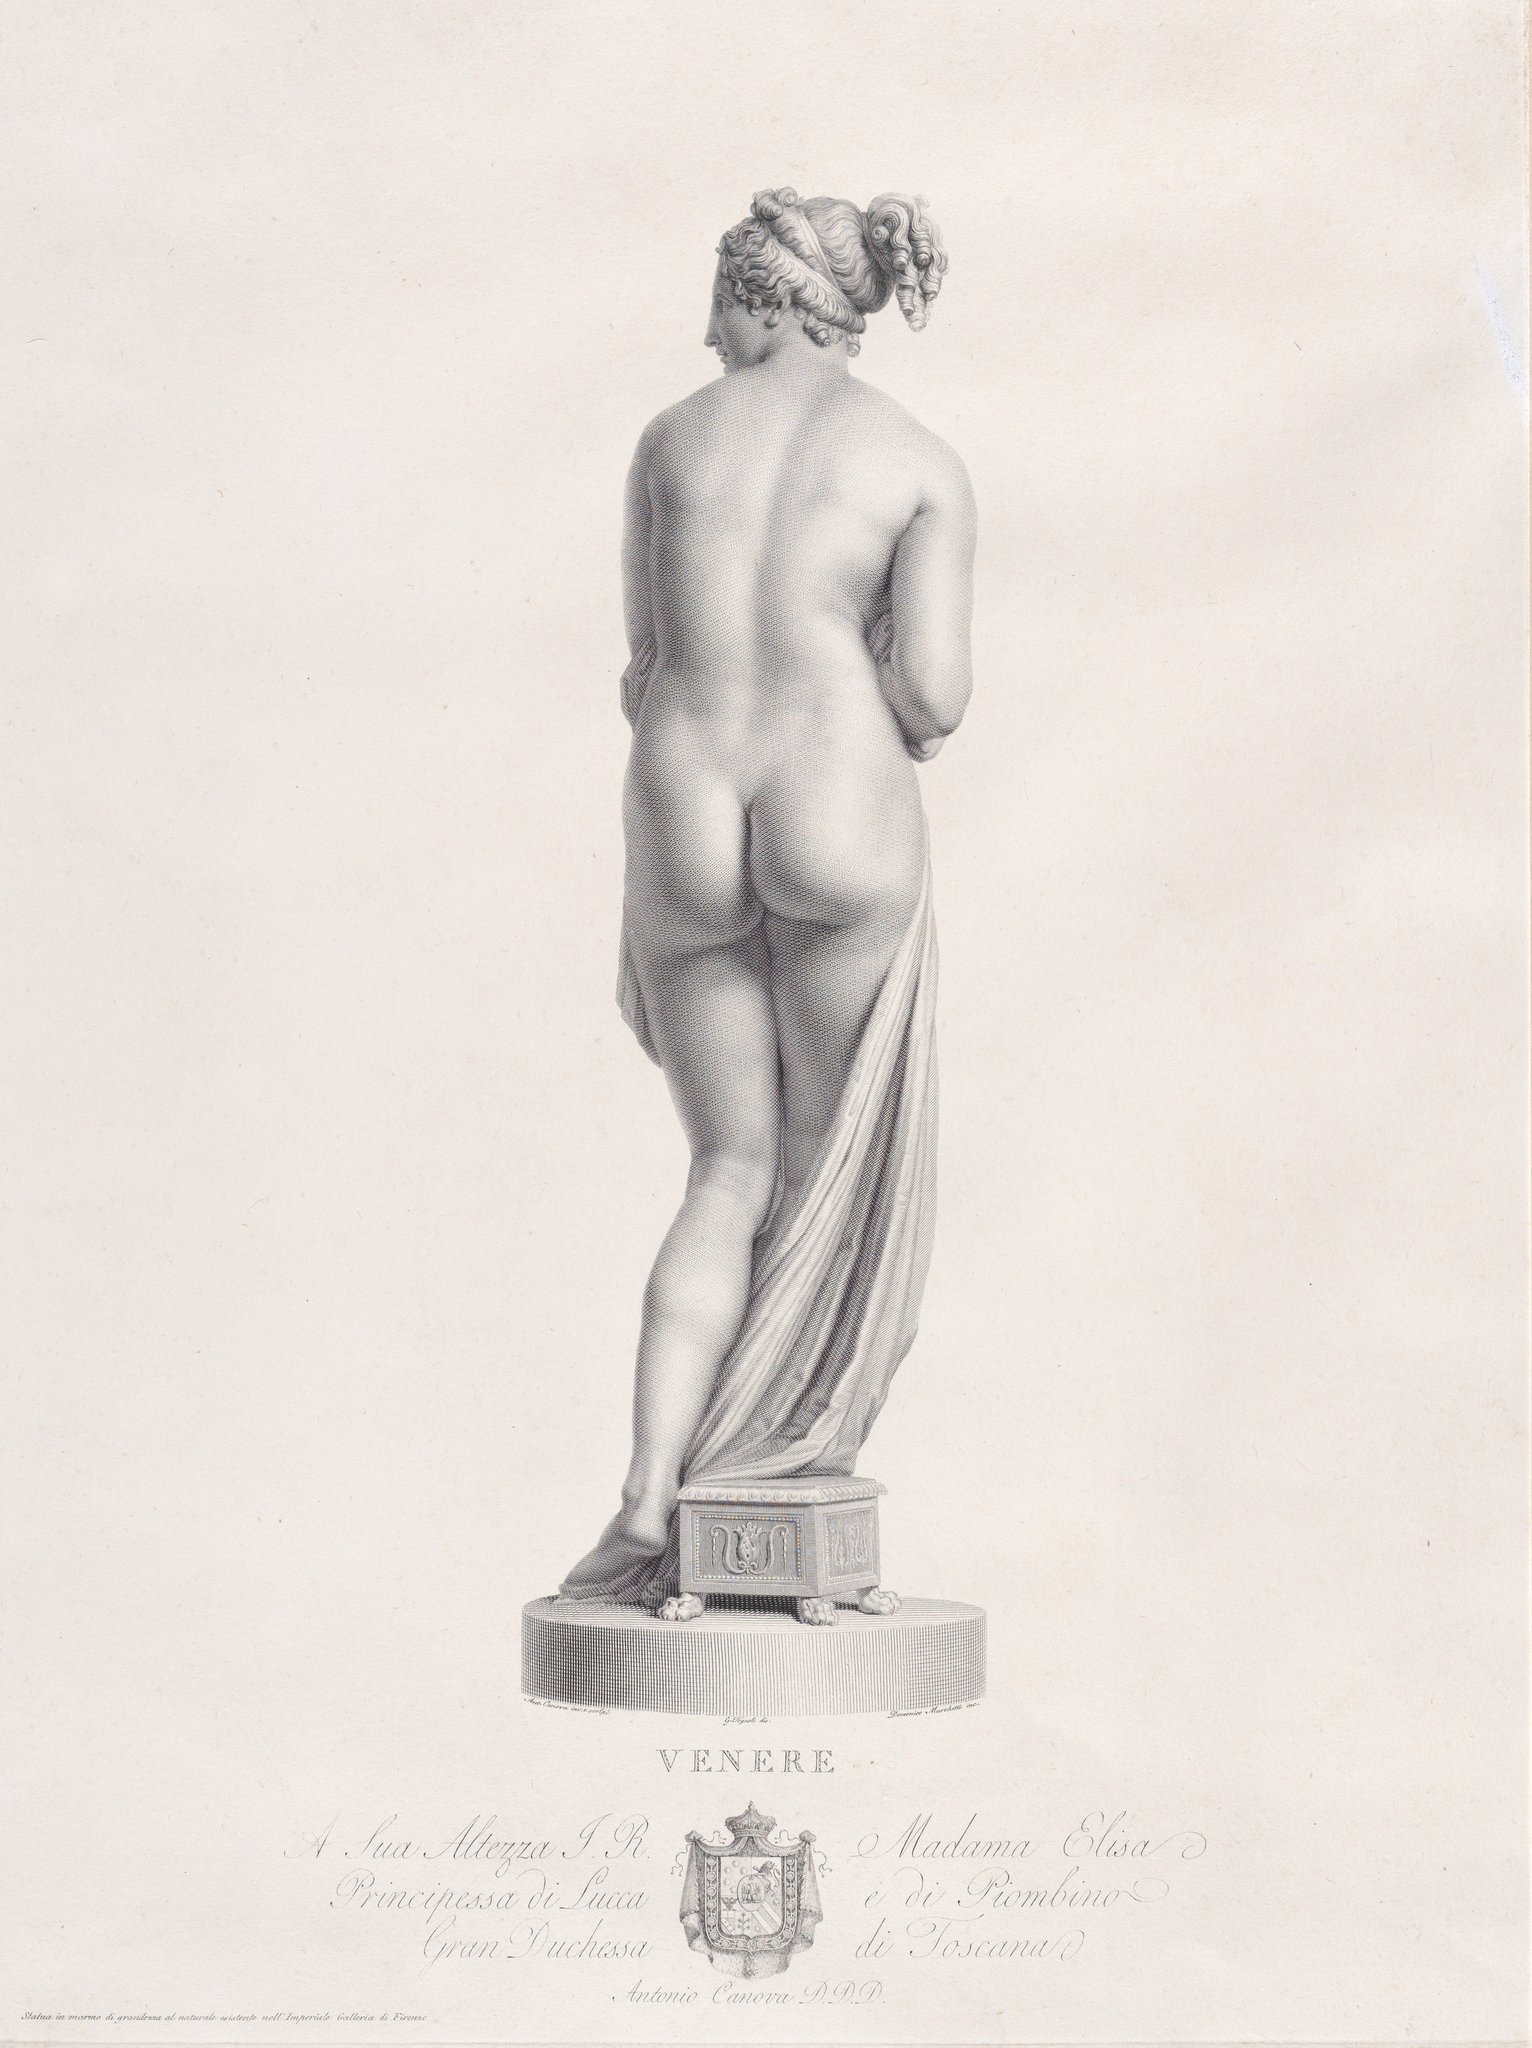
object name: print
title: Venus, back view, from "Oeuvre de Canova: Recueil de Statues..."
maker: domenico marchetti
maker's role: artist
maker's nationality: italian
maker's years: 1780-1844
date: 1817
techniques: engraving, etching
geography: rome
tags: female nudes,venus